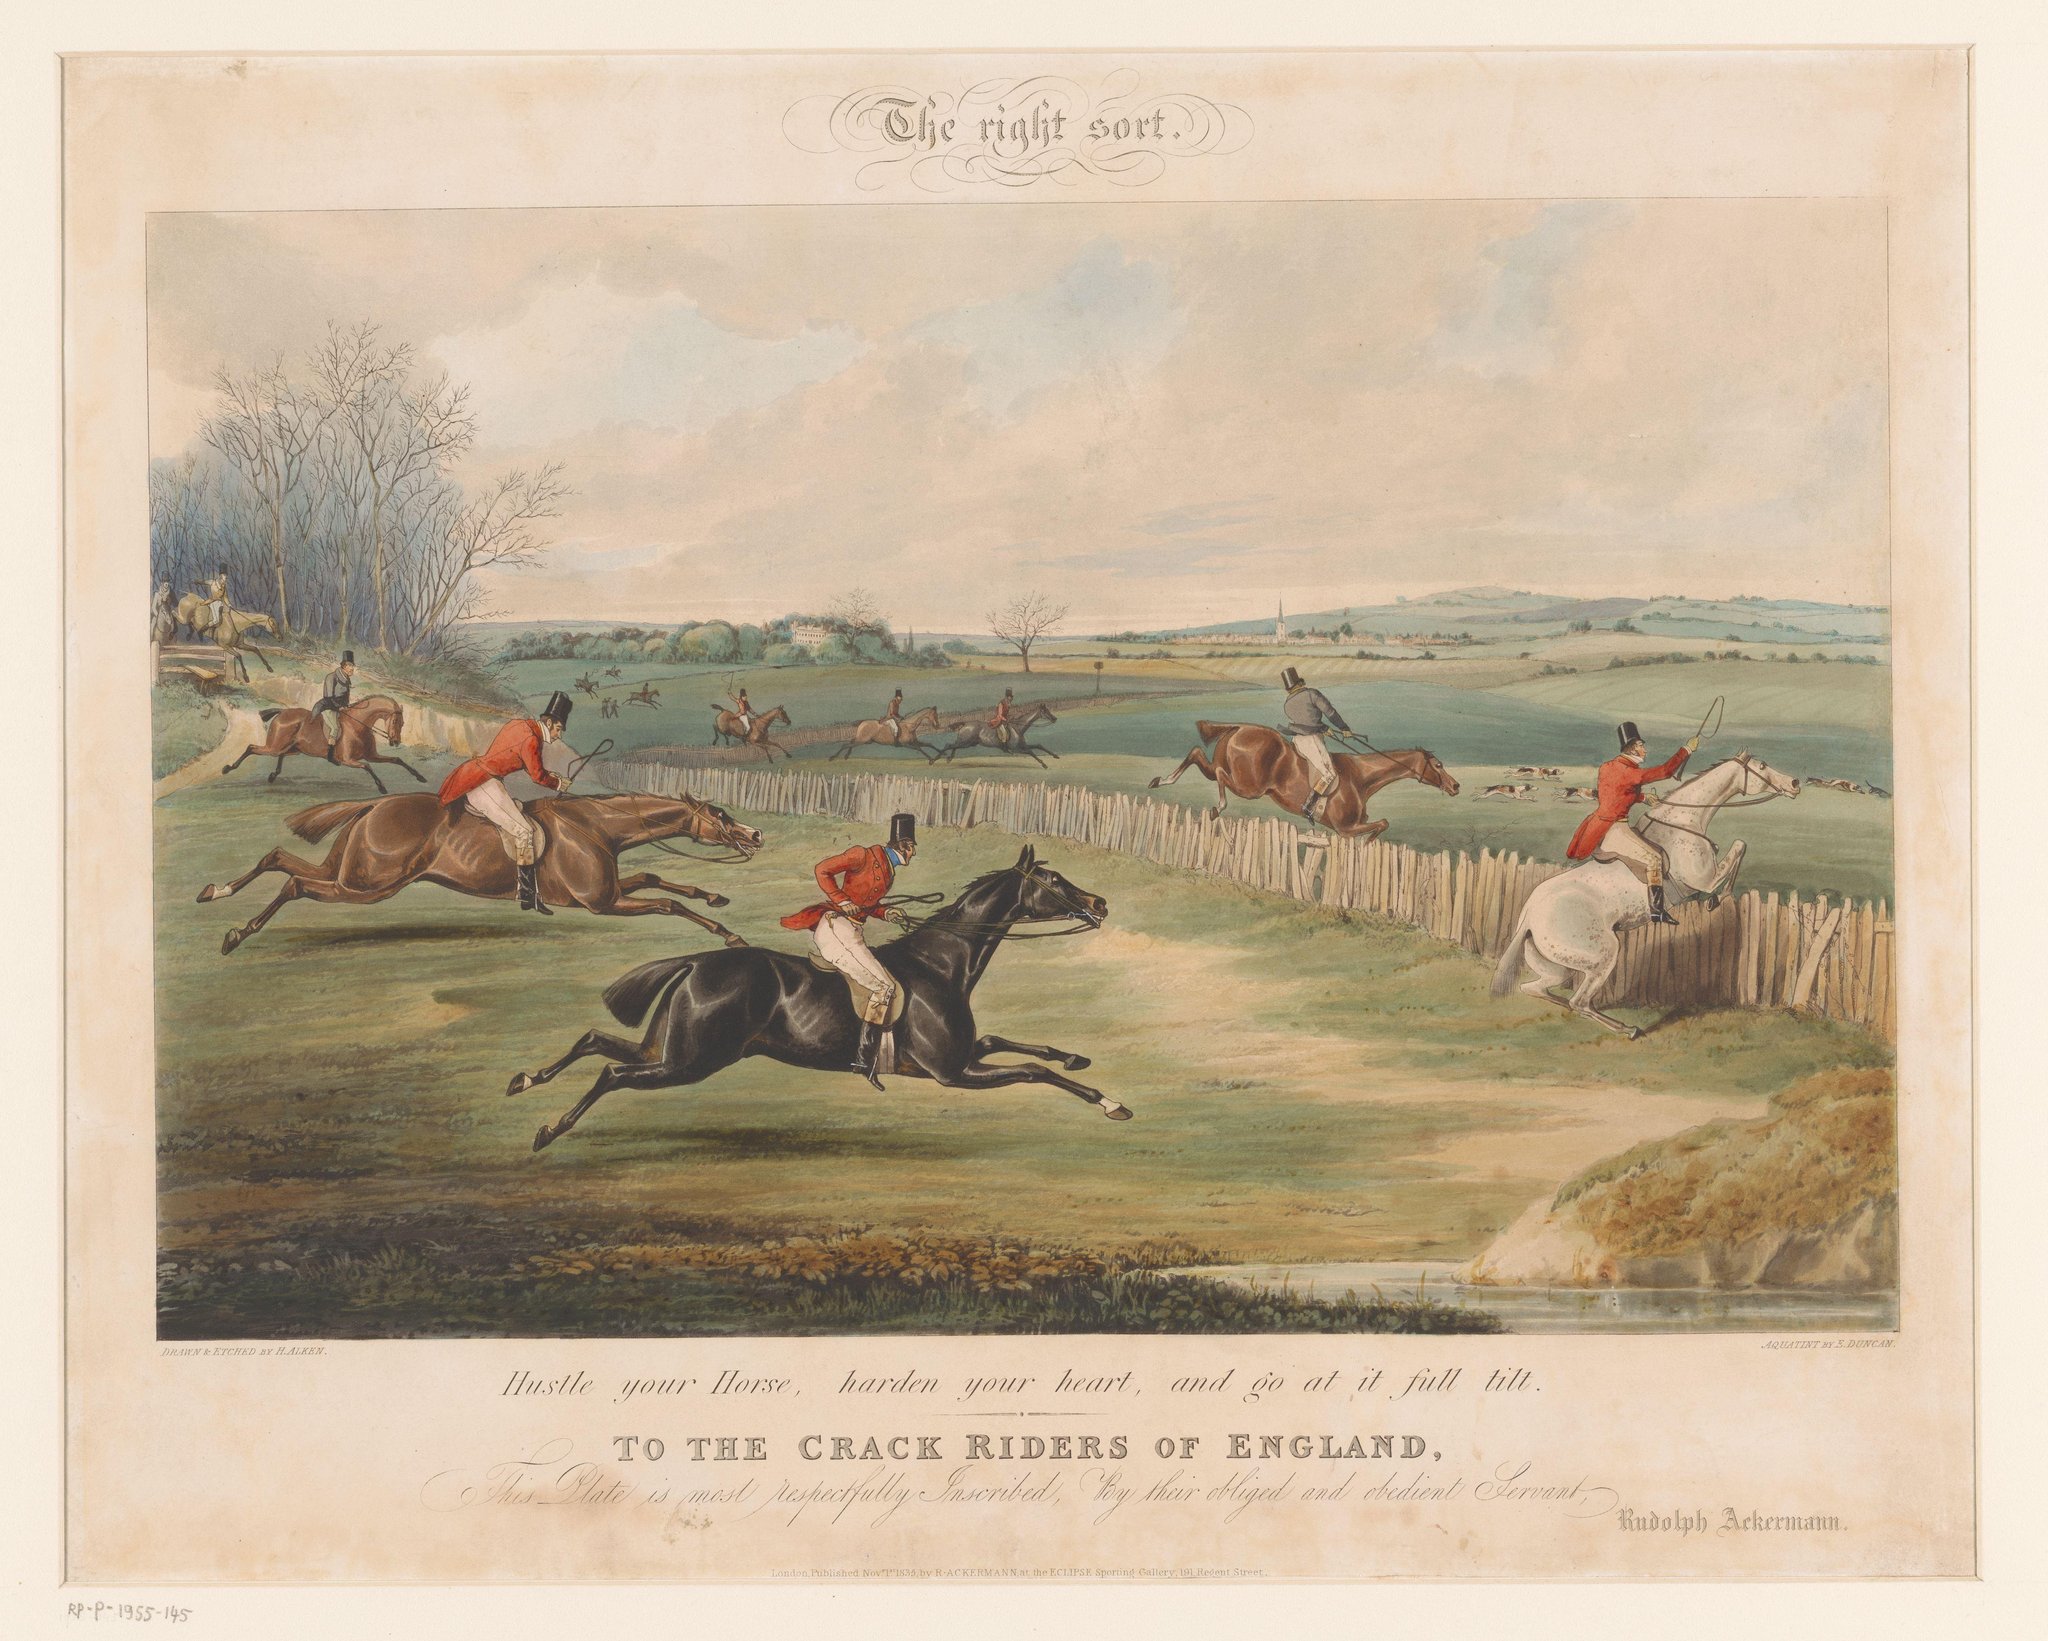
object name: print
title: Jachtpaarden met ruiters springen over hekken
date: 1835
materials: paper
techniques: aquatint, etching, hand coloring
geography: london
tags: hunting, chase, obedience; 'obedienza' (ripa), horse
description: Tekst in het Engels in de ondermarge: 'Hustle your Horse, harden your heart, and go at it full tilt.'.